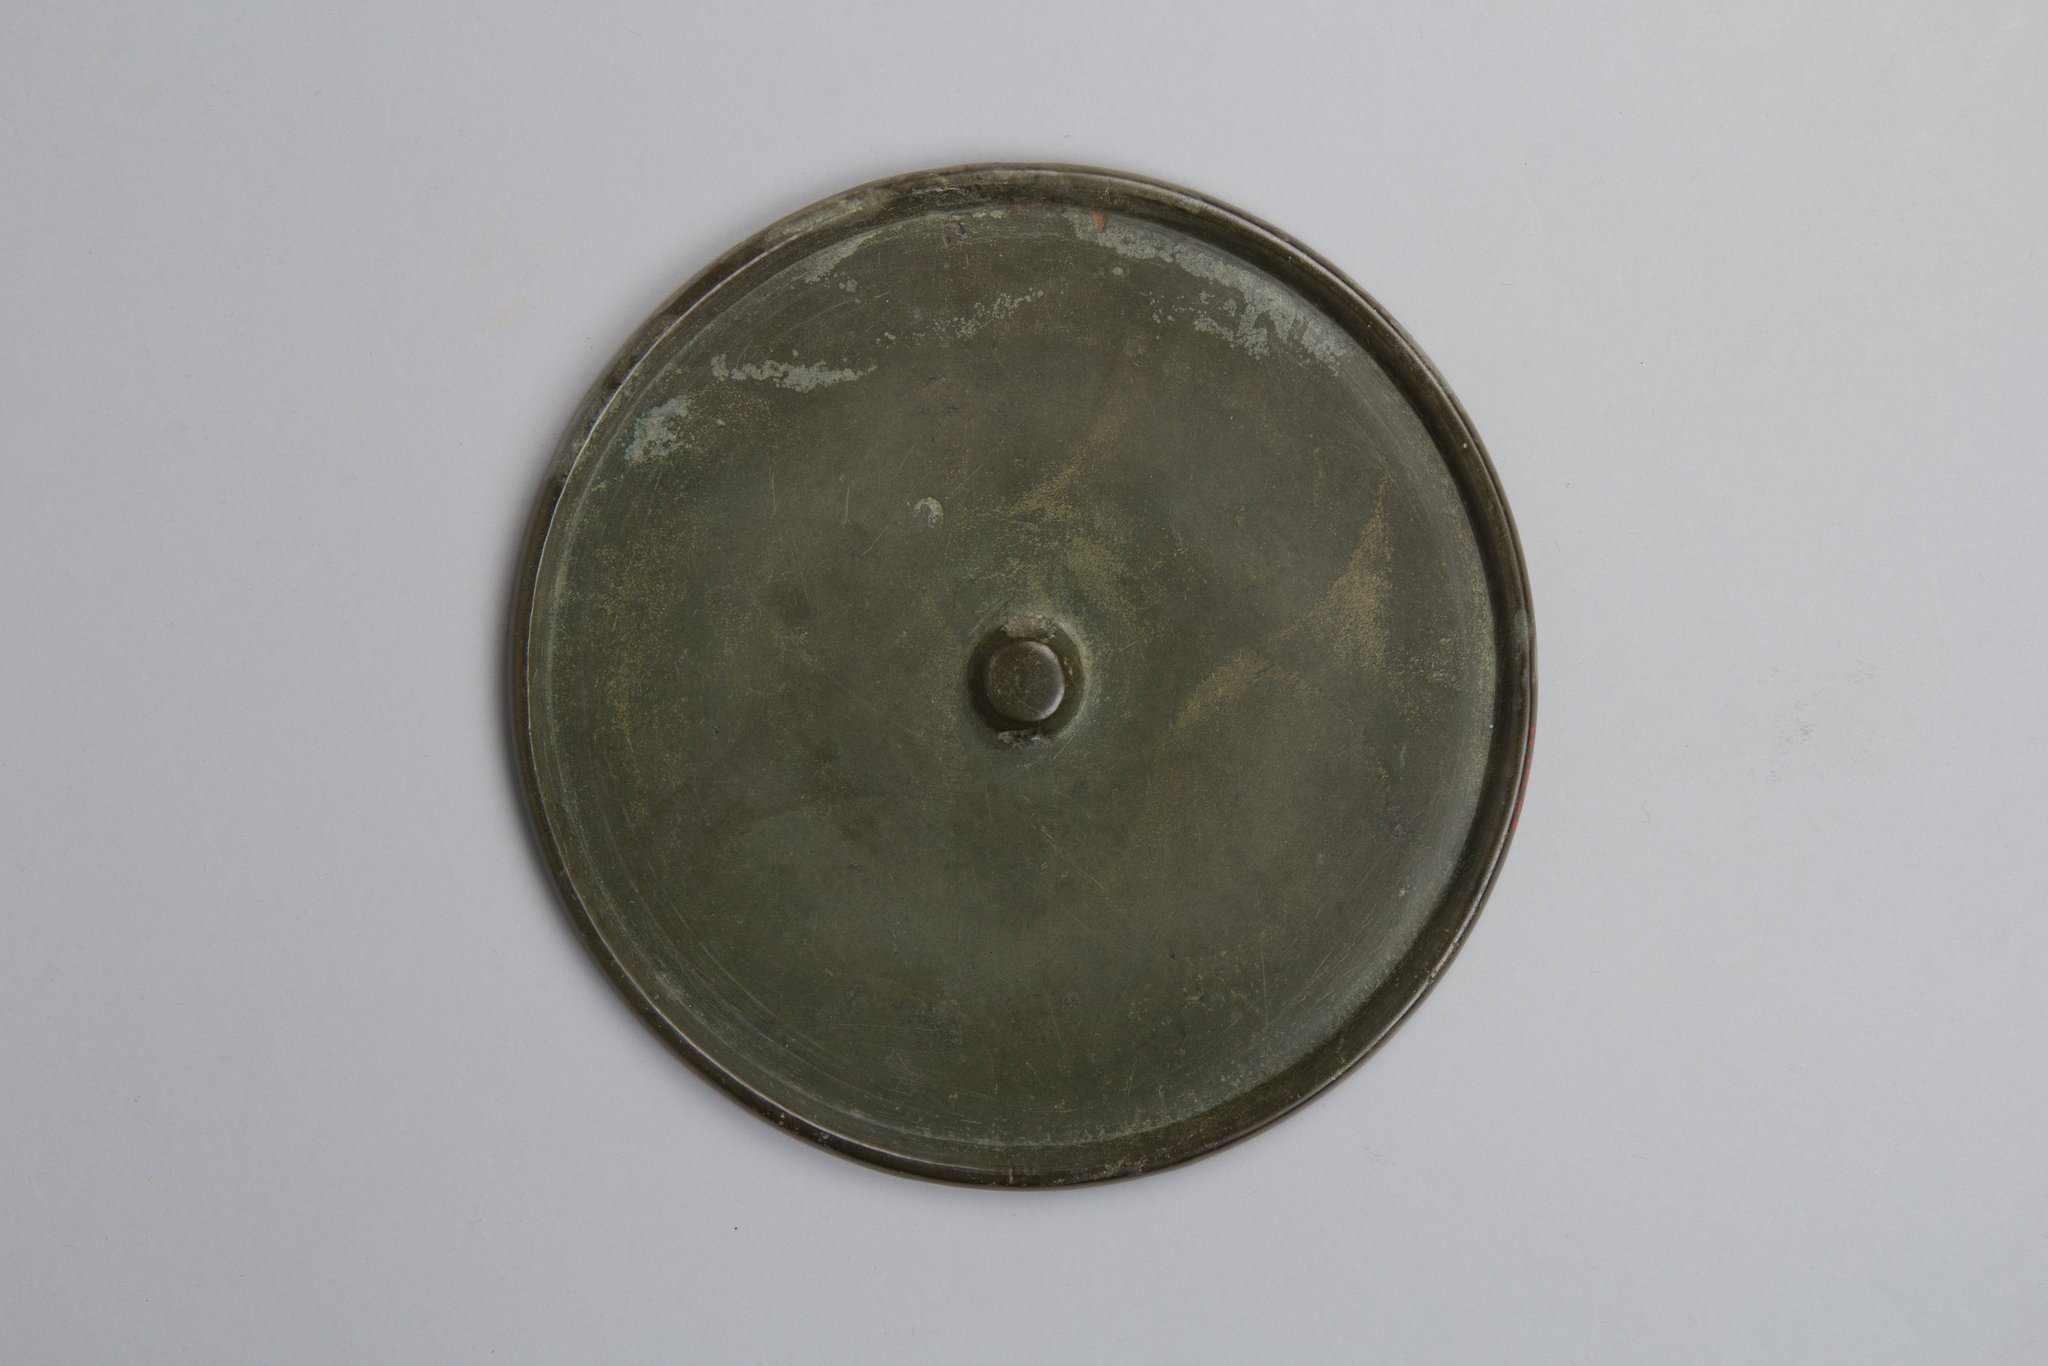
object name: mirror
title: Mirror with Incised Design of Buddha Triad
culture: korean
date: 1401-1500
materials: bronze